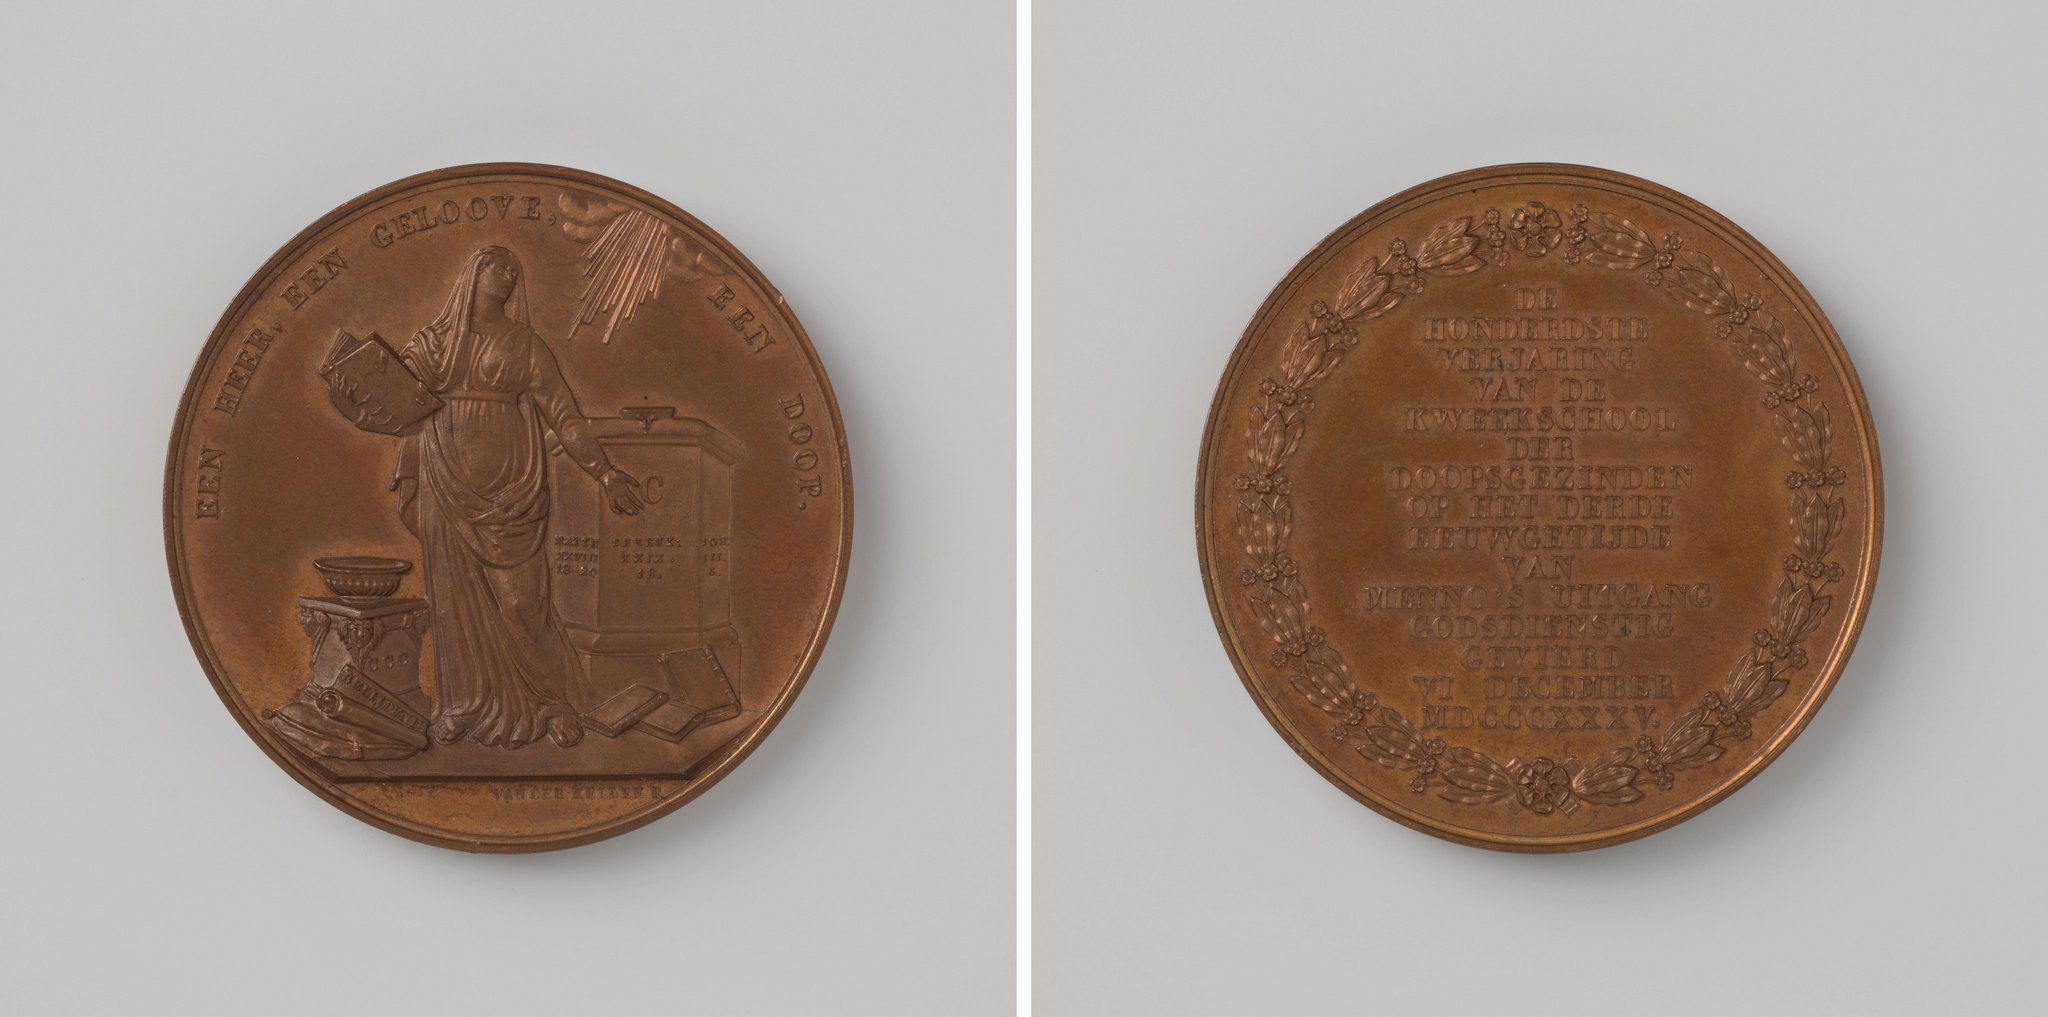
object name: history medal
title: Honderdjarig bestaan van de Kweekschool der Doopsgezinden te Amsterdam 1835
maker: david van der kellen (1804-1879)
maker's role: die cutter, draughtsman, print maker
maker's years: 1804-1879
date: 1835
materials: bronze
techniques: striking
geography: utrecht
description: Bronzen penning, op de voorzijde een gesluierde vrouw met bijbel, beschenen vanuit de hemel, met de rechterhand wijzend op drie boeken naast een altaar, links een doopbekken op een voetstuk waarvoor een document op een kussen, met omschrift, op de keerzijde vijftien regels tekst binnen een mirtenkrans.